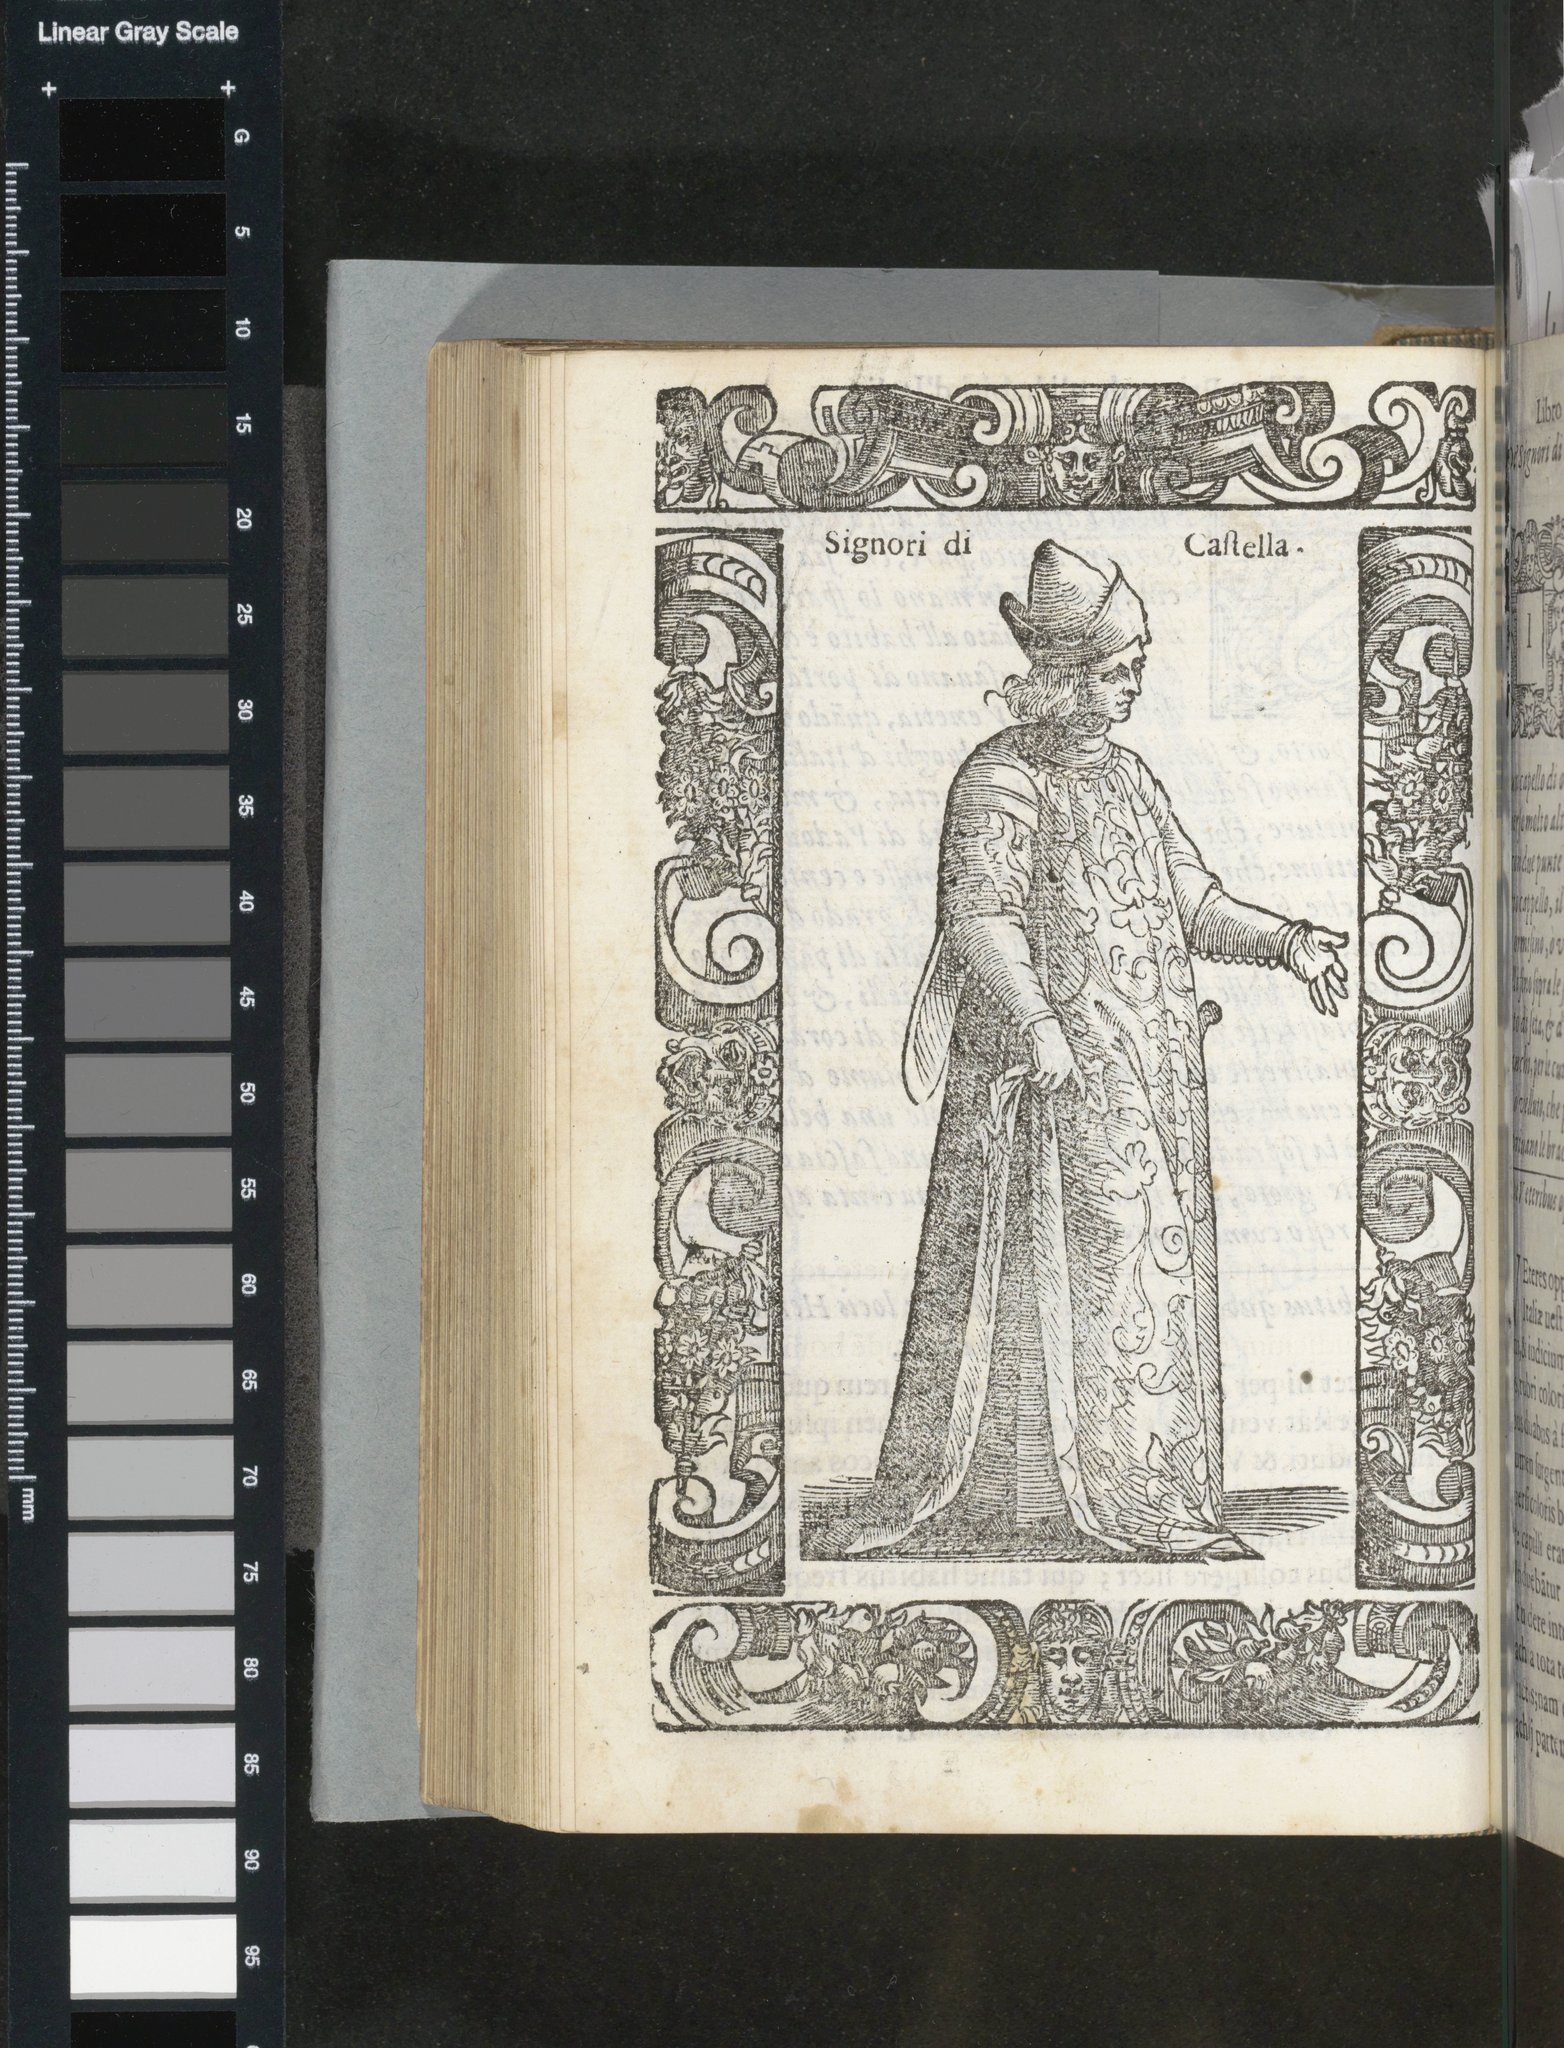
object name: costume print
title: Signori di castella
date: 1598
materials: paper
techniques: woodcut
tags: fashion plates